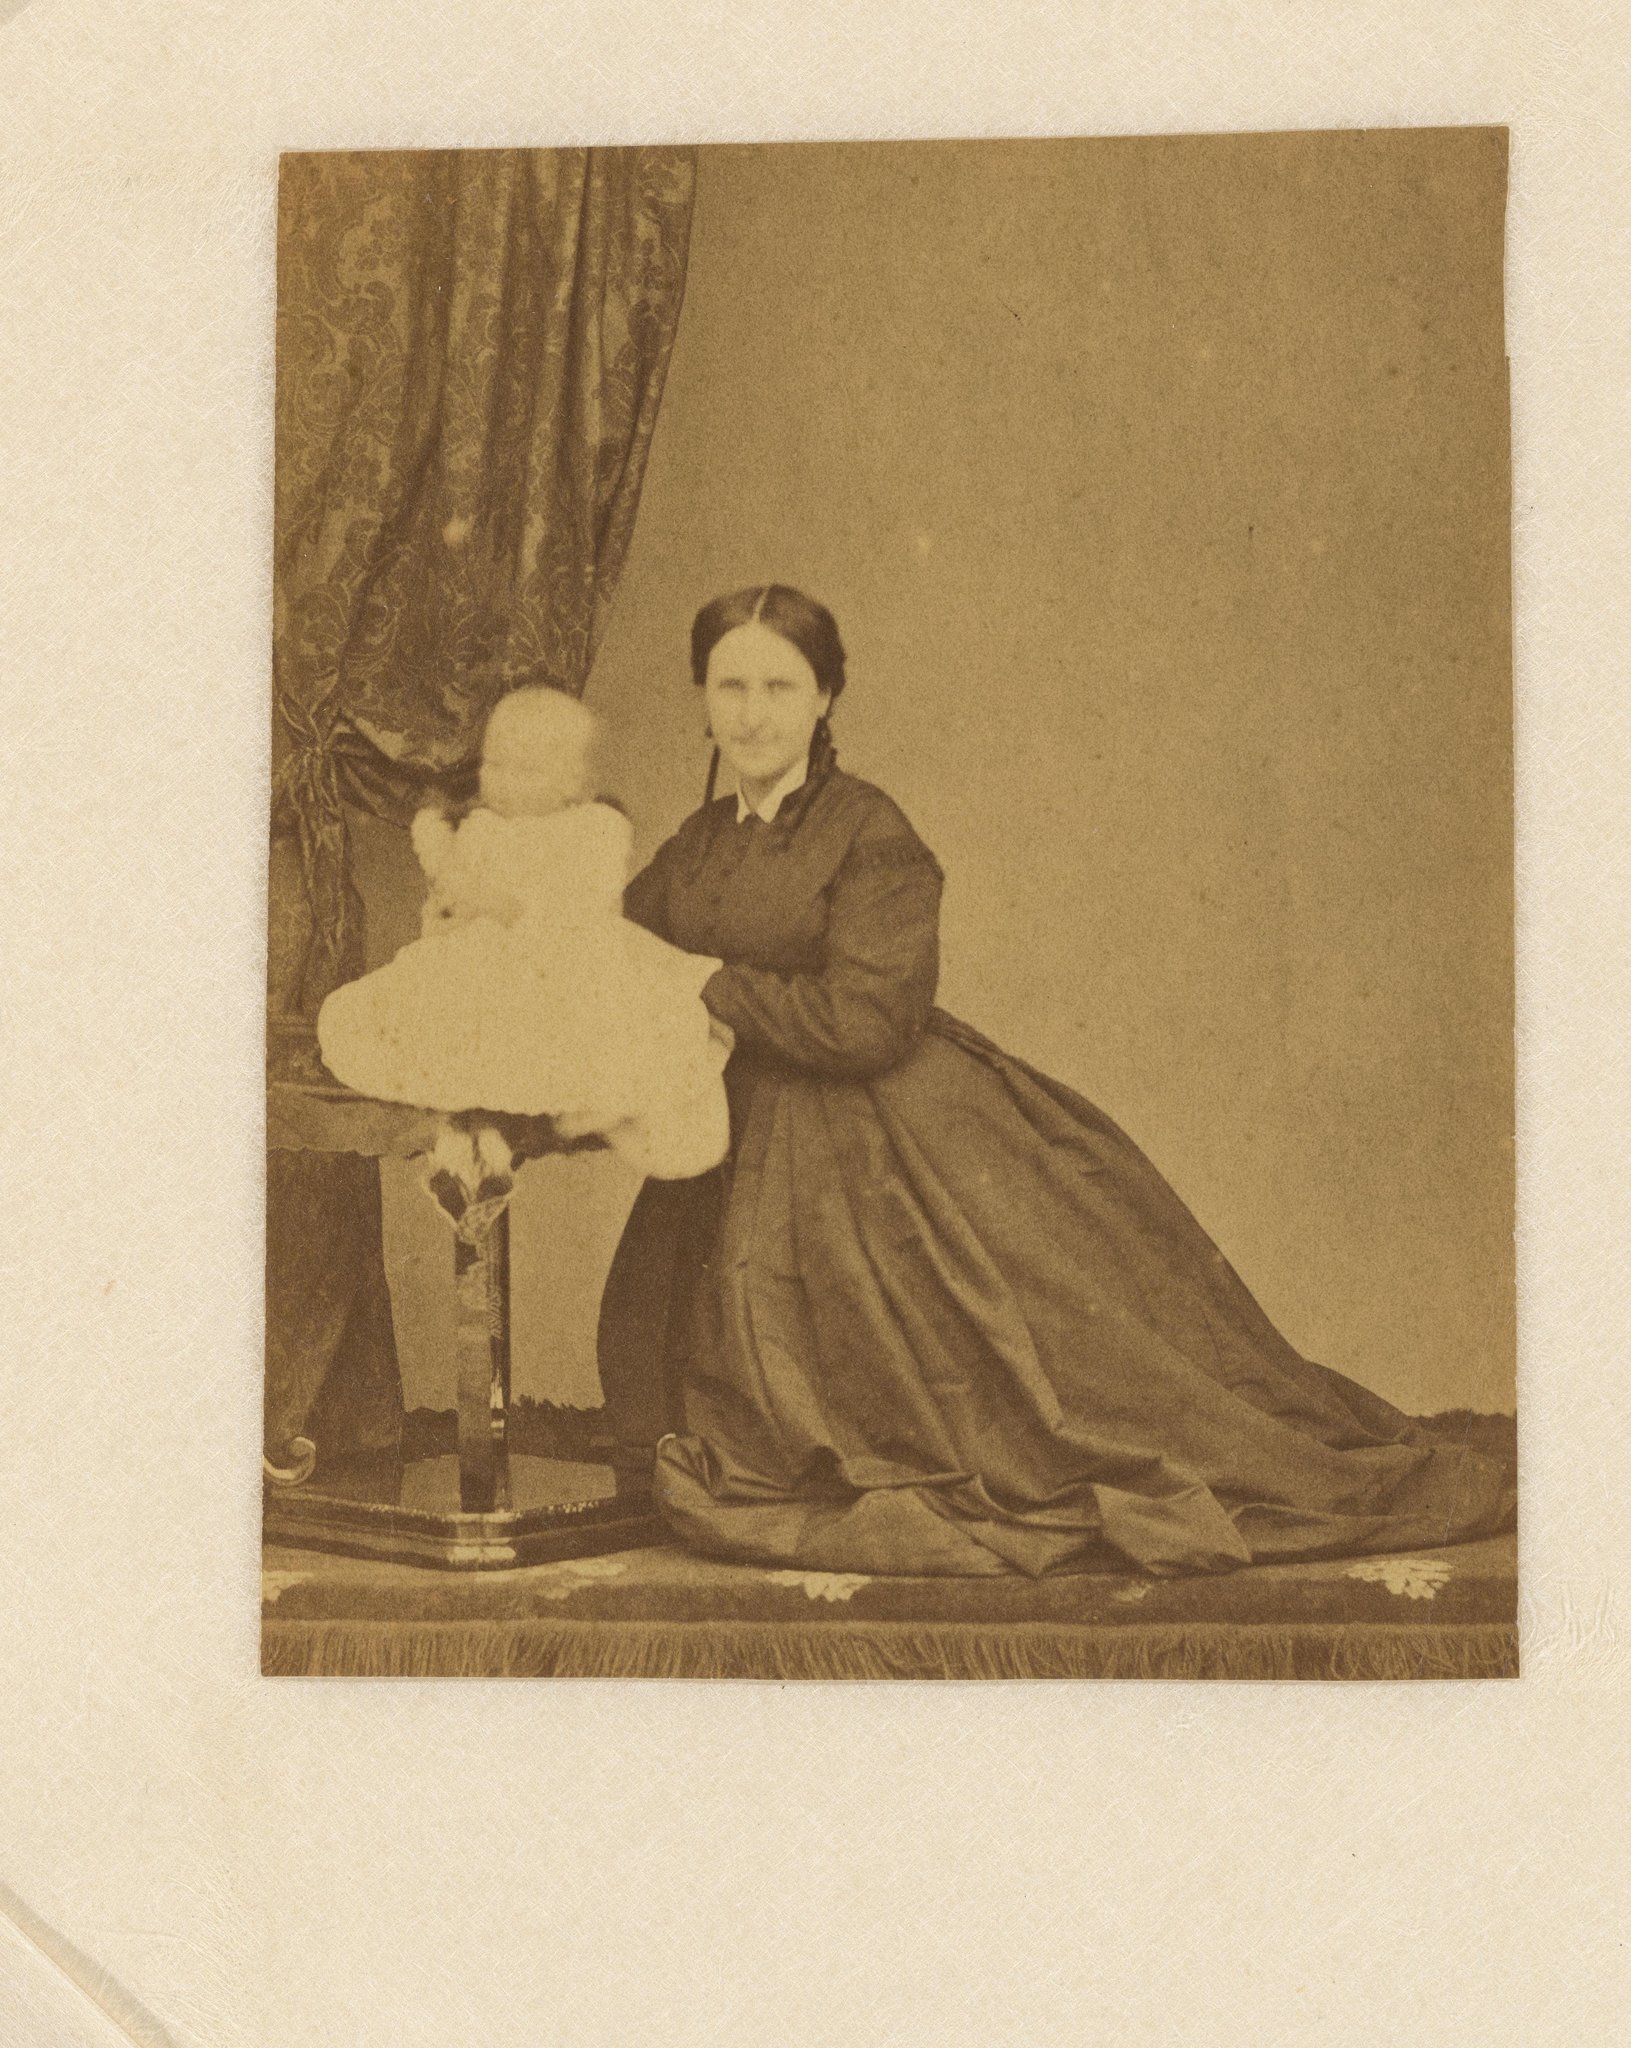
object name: photograph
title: Portret van een zittende vrouw met kind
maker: Anonymous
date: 1865-1875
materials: paper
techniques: albumen print